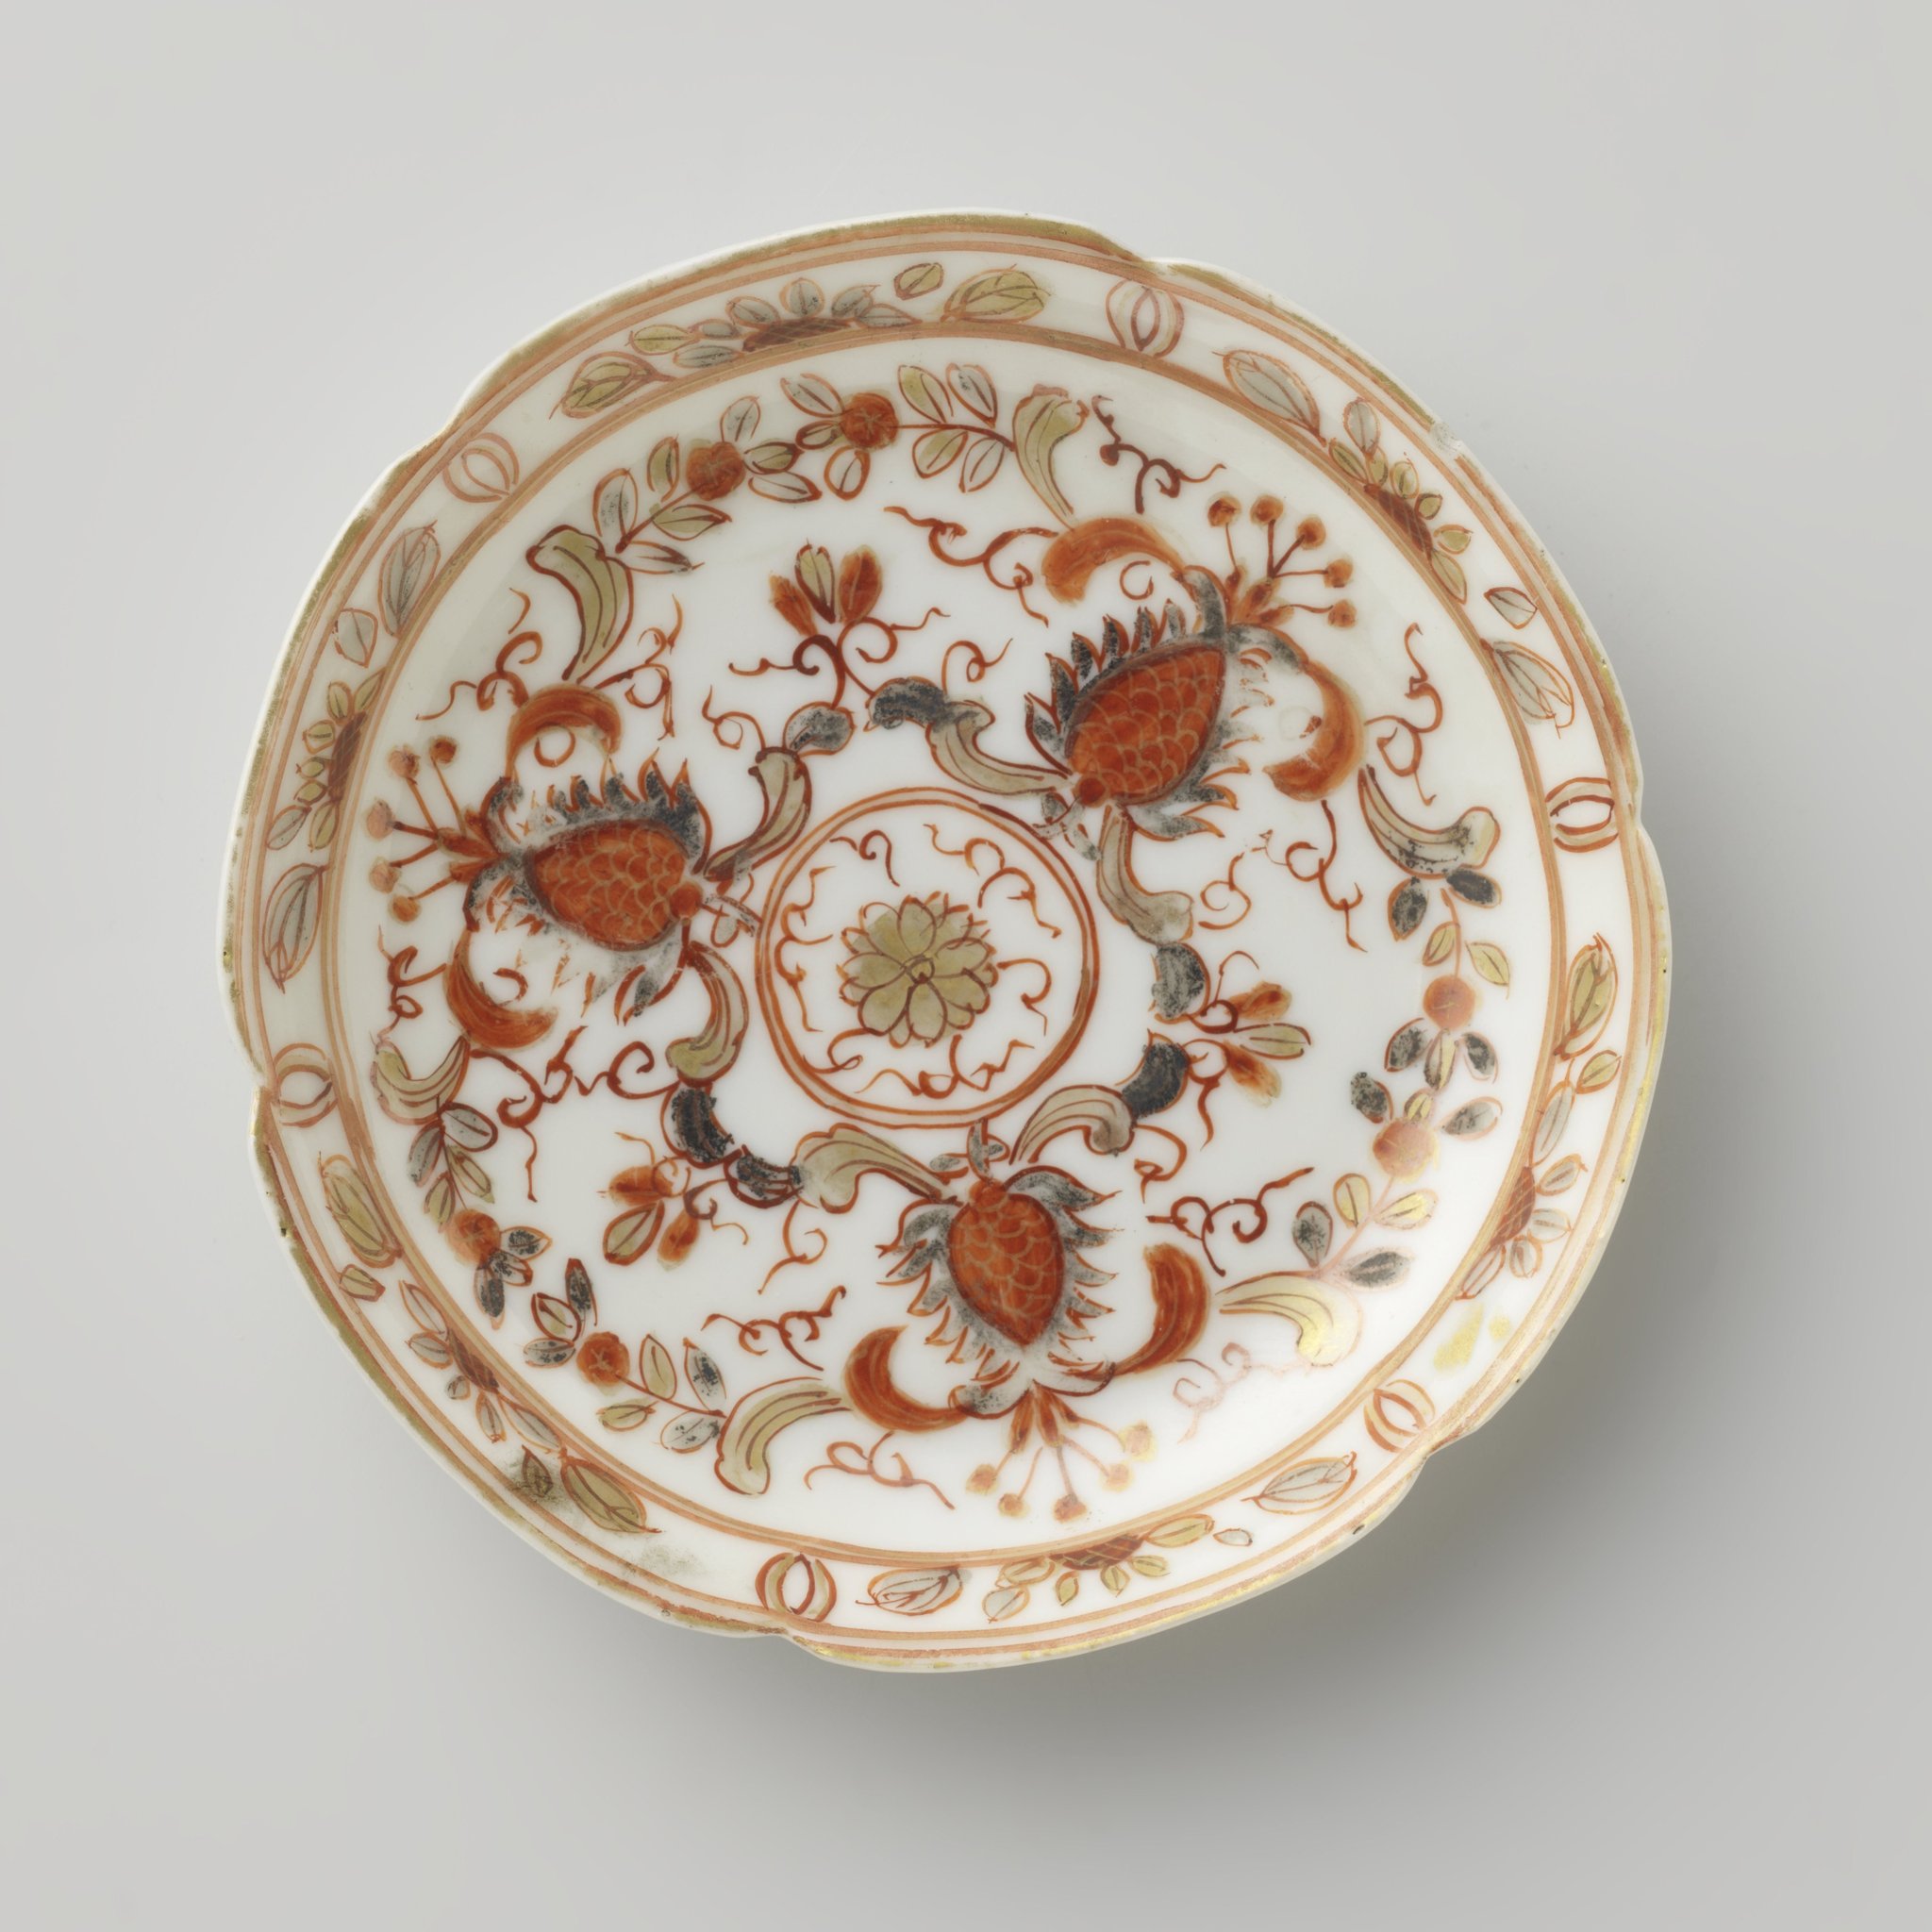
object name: kop en schotel, kop en schotel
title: Saucer with scrolls and stylised flowers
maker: Anonymous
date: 1700-1724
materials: glaze, gold, paint, porcelain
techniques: firing, gilding, turning, vitrification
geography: china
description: Kop en schotel, versierd met palmetten in rood goud en zwart. Melk en bloed.